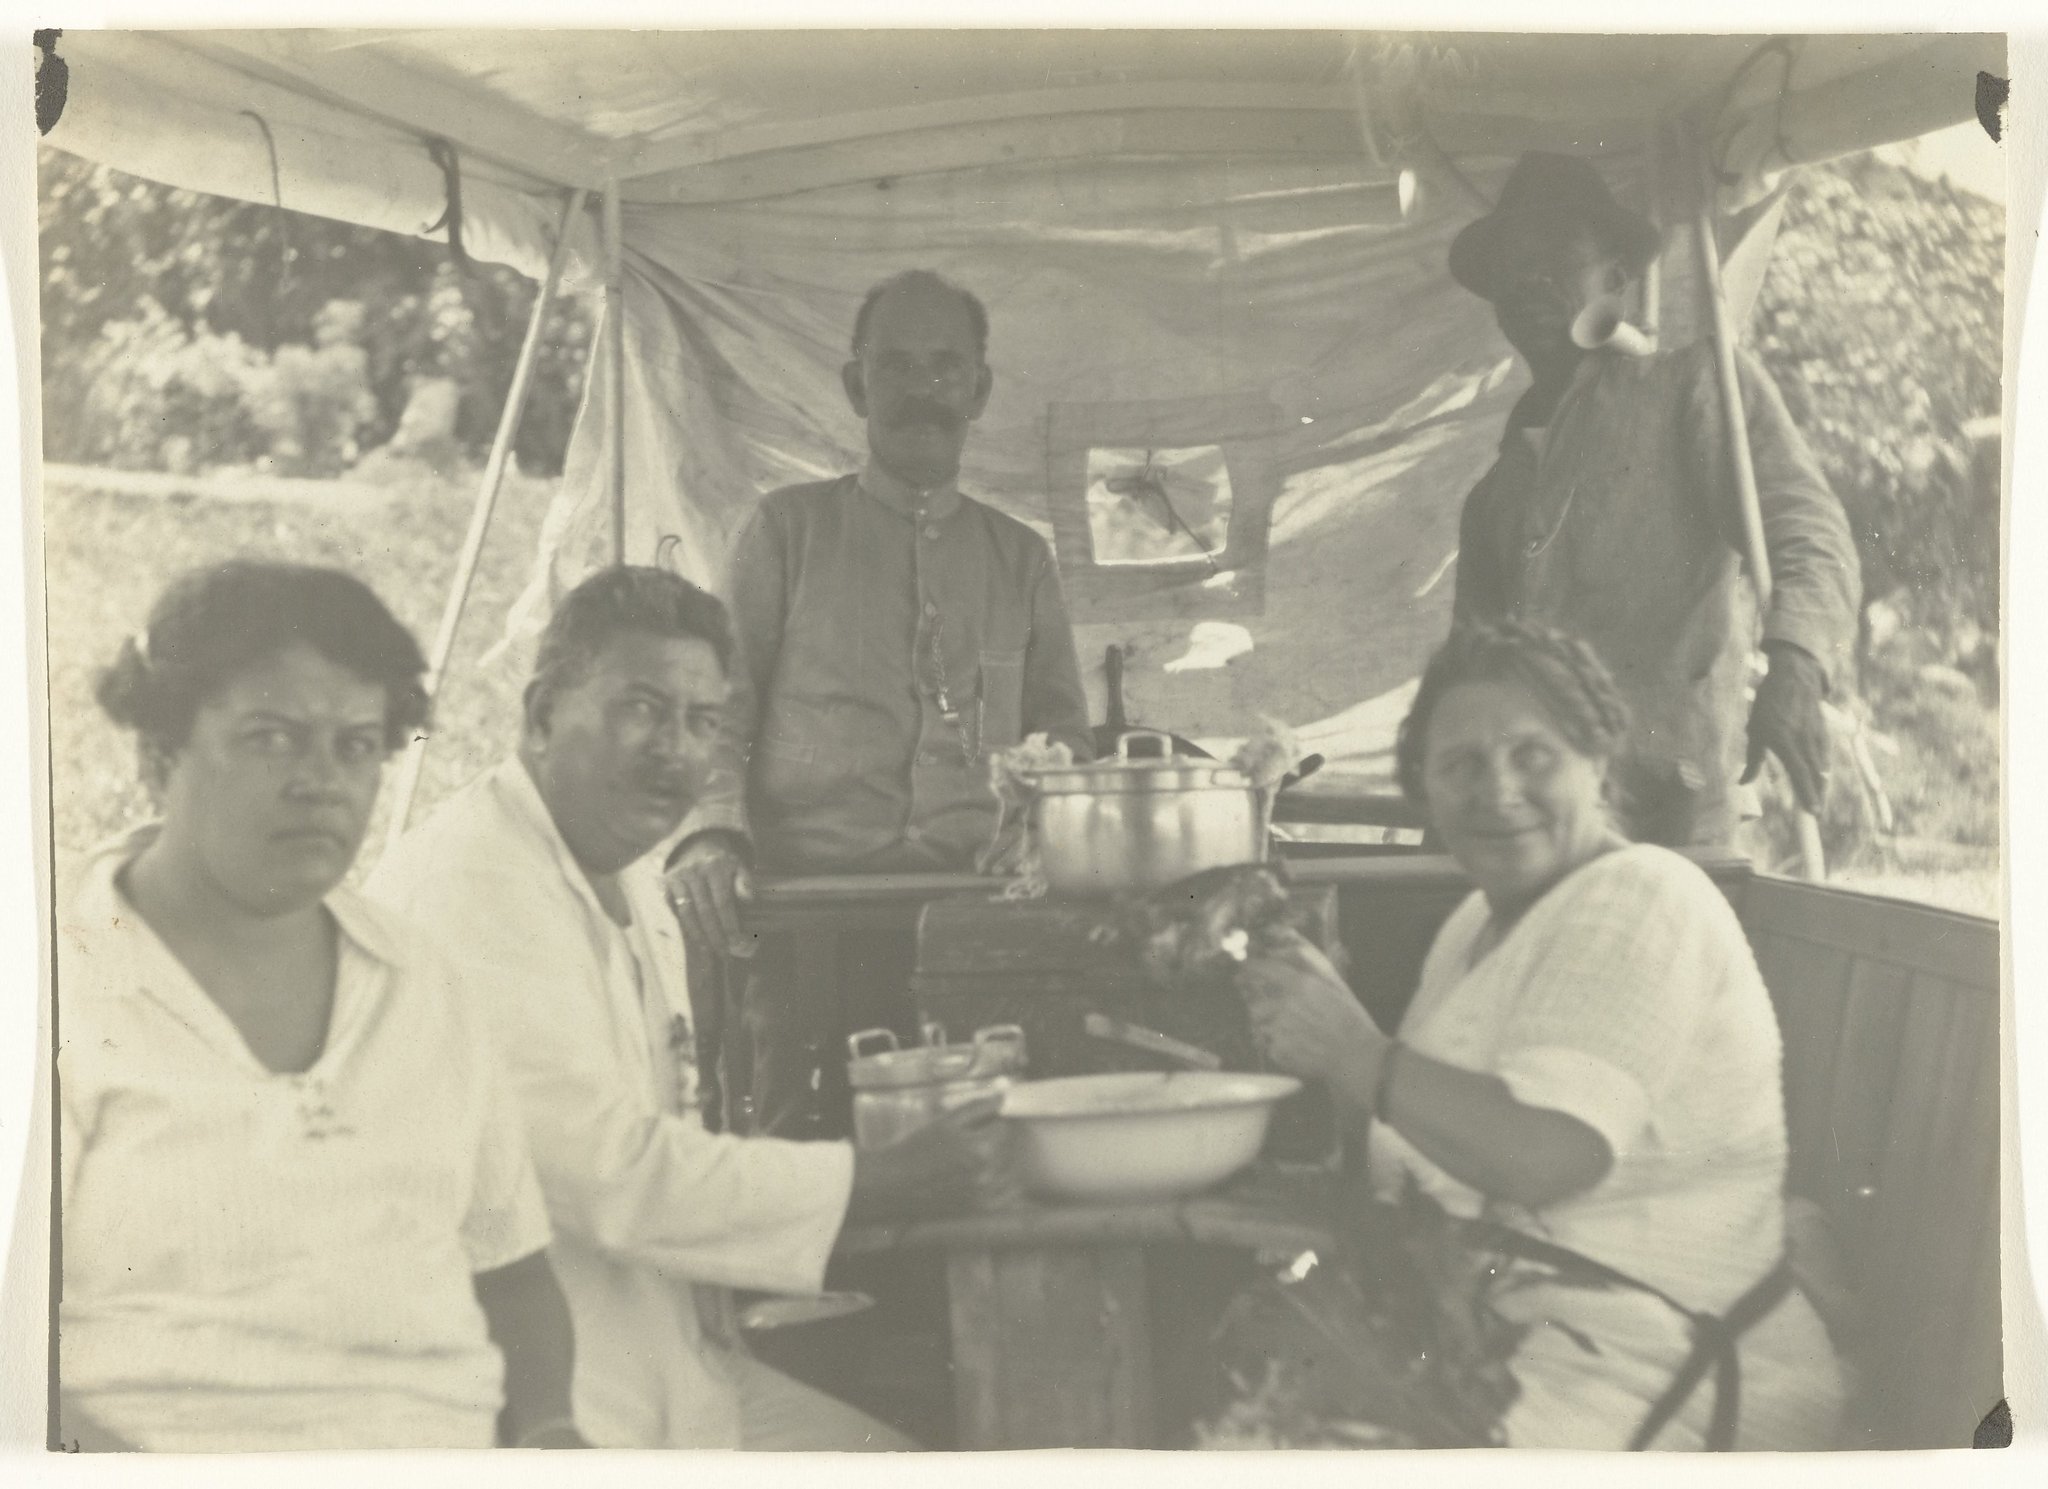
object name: photograph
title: Doktersbezoek per boot op plantage Accaribo te Suriname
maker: Anonymous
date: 1916-1930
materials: photographic support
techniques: photography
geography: suriname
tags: theodoor brouwers, plantation, suriname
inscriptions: inscription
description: In de periode 1911-1932 woonde op plantage Accaribo in Suriname de familie Brouwers van wie de foto's afkomstig zijn. Rond 1910 vond Theodoor Brouwers werk op plantage Accaribo. In 1929 werd hij eigenaar van de plantage.